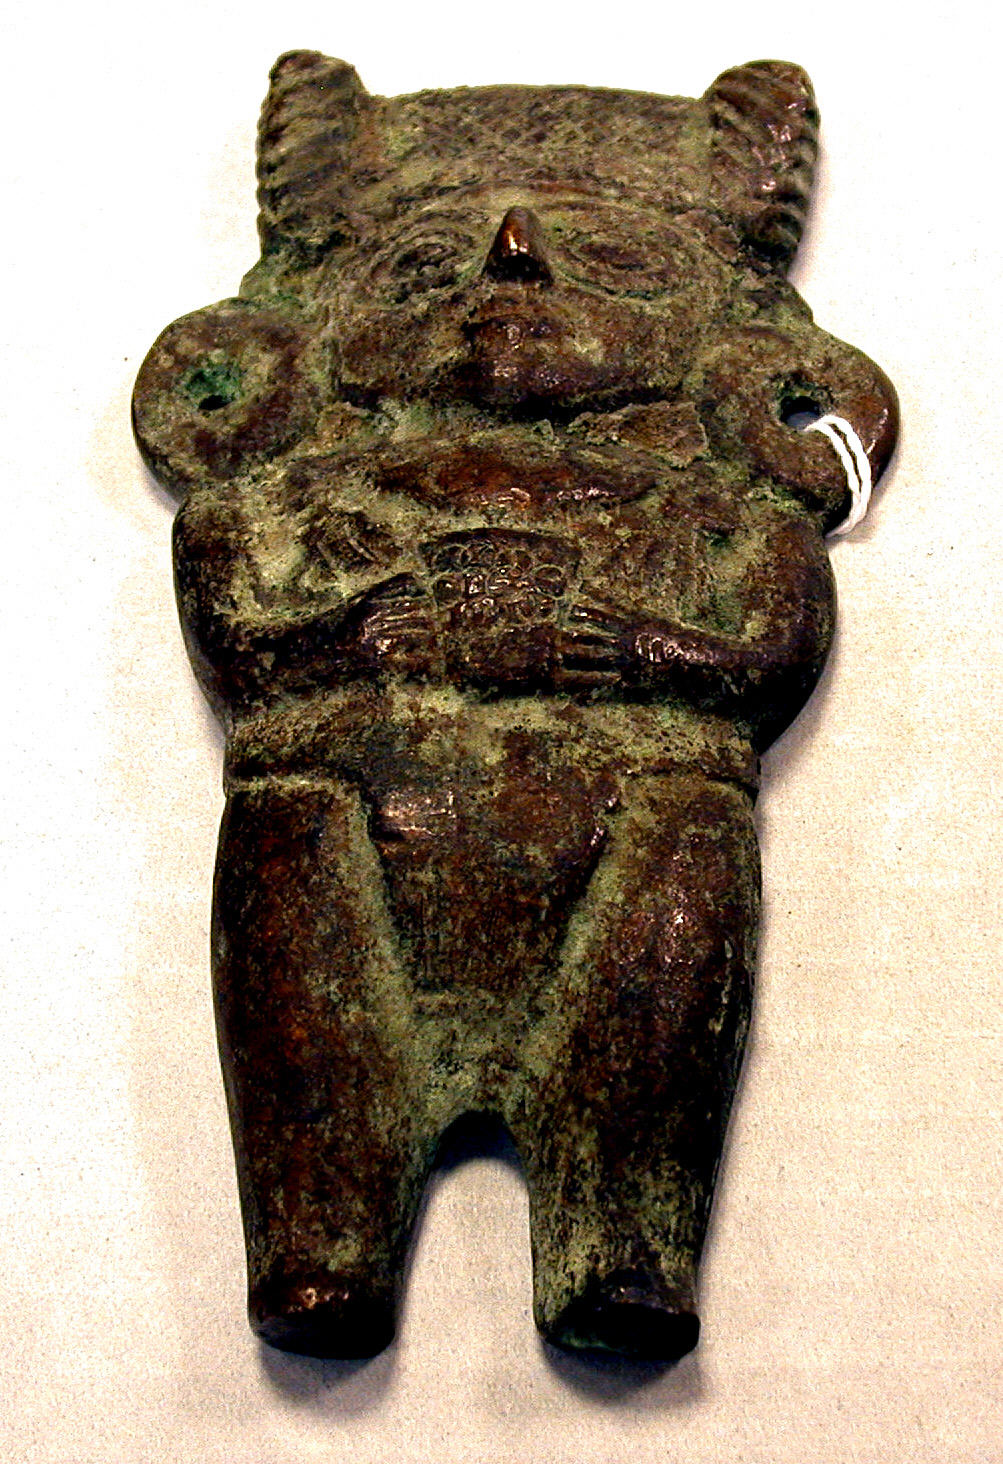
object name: ornament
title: Cast Bronze Figure Ornament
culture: peruvian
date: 900-1470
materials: bronze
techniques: casting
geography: peru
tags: human figures